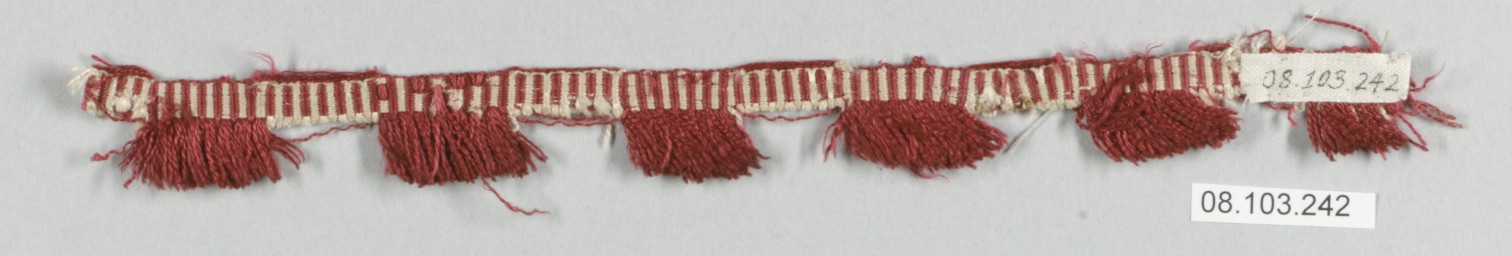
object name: gimp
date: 1701-1800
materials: silk